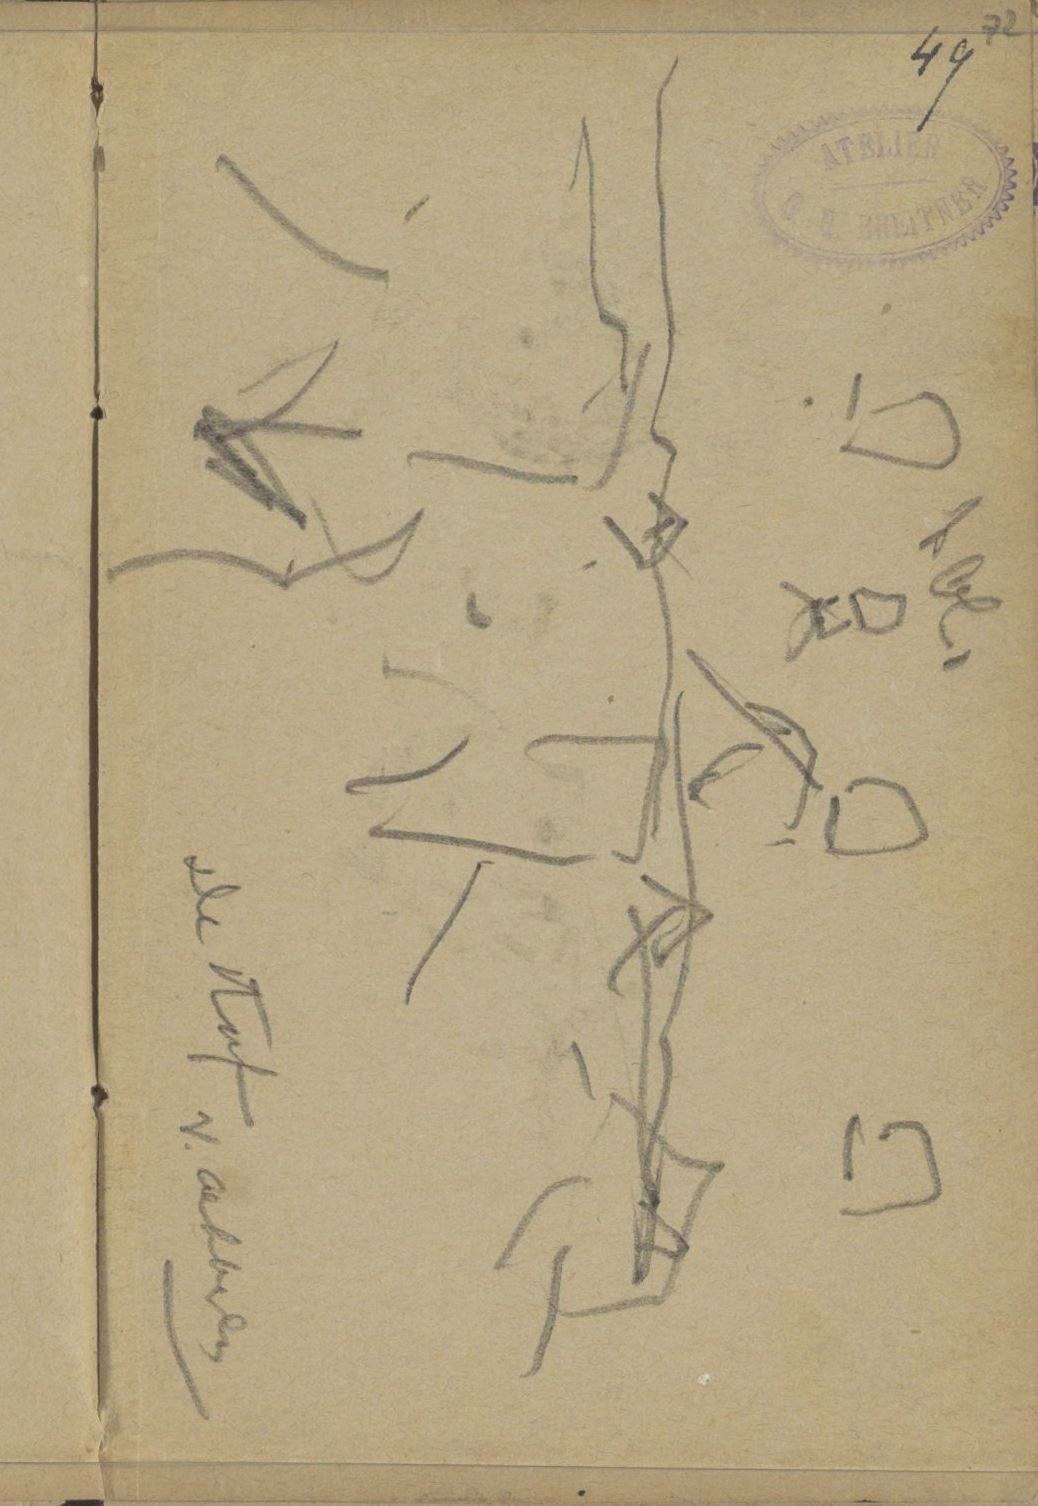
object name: sketchbook leaf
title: Soldaten, mogelijk te paard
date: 1887-1891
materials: paper, pencil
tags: division of armed forces (+ land forces), the soldier; the soldier's life, horse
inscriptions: workshop stamp: Lugt 291d, annotation: ‘[...]/ De staf/ v. [...]’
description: Pagina 72 uit een schetsboek met 83 bladen.